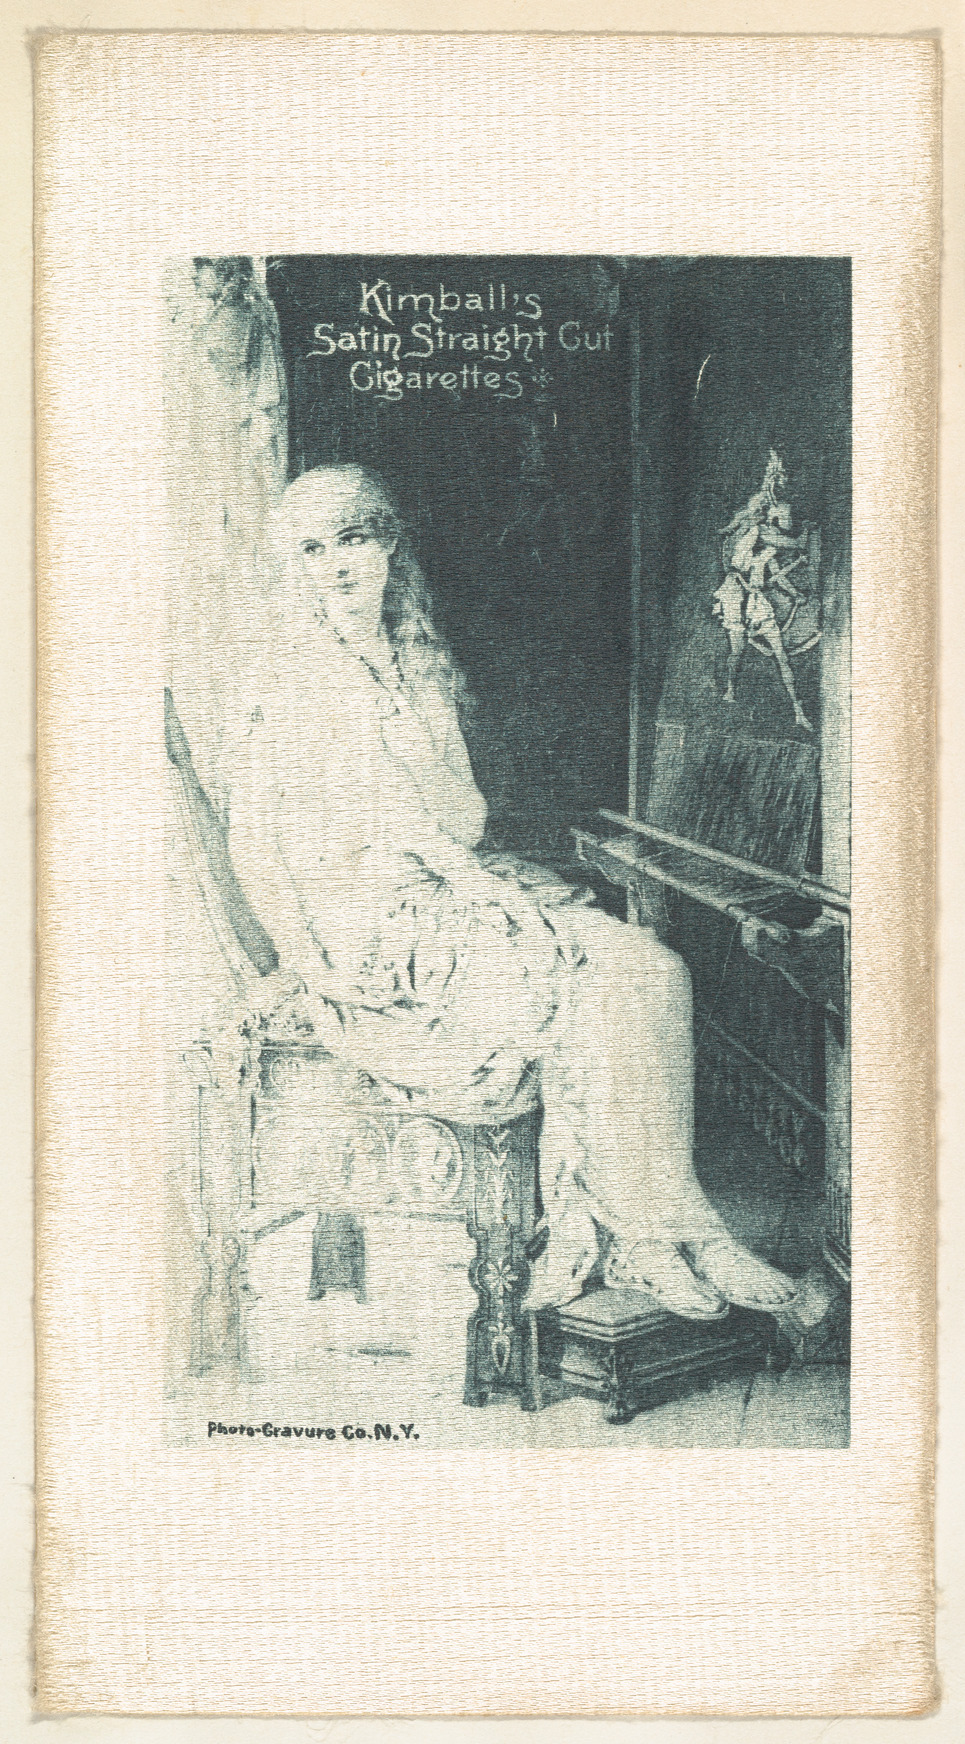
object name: print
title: Seated woman (on white silk), from the Girl Art Subjects series (N193) issued by Wm. S. Kimball & Co.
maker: william s. kimball & company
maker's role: publisher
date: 1890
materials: silk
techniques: lithography, printing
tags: portraits,women